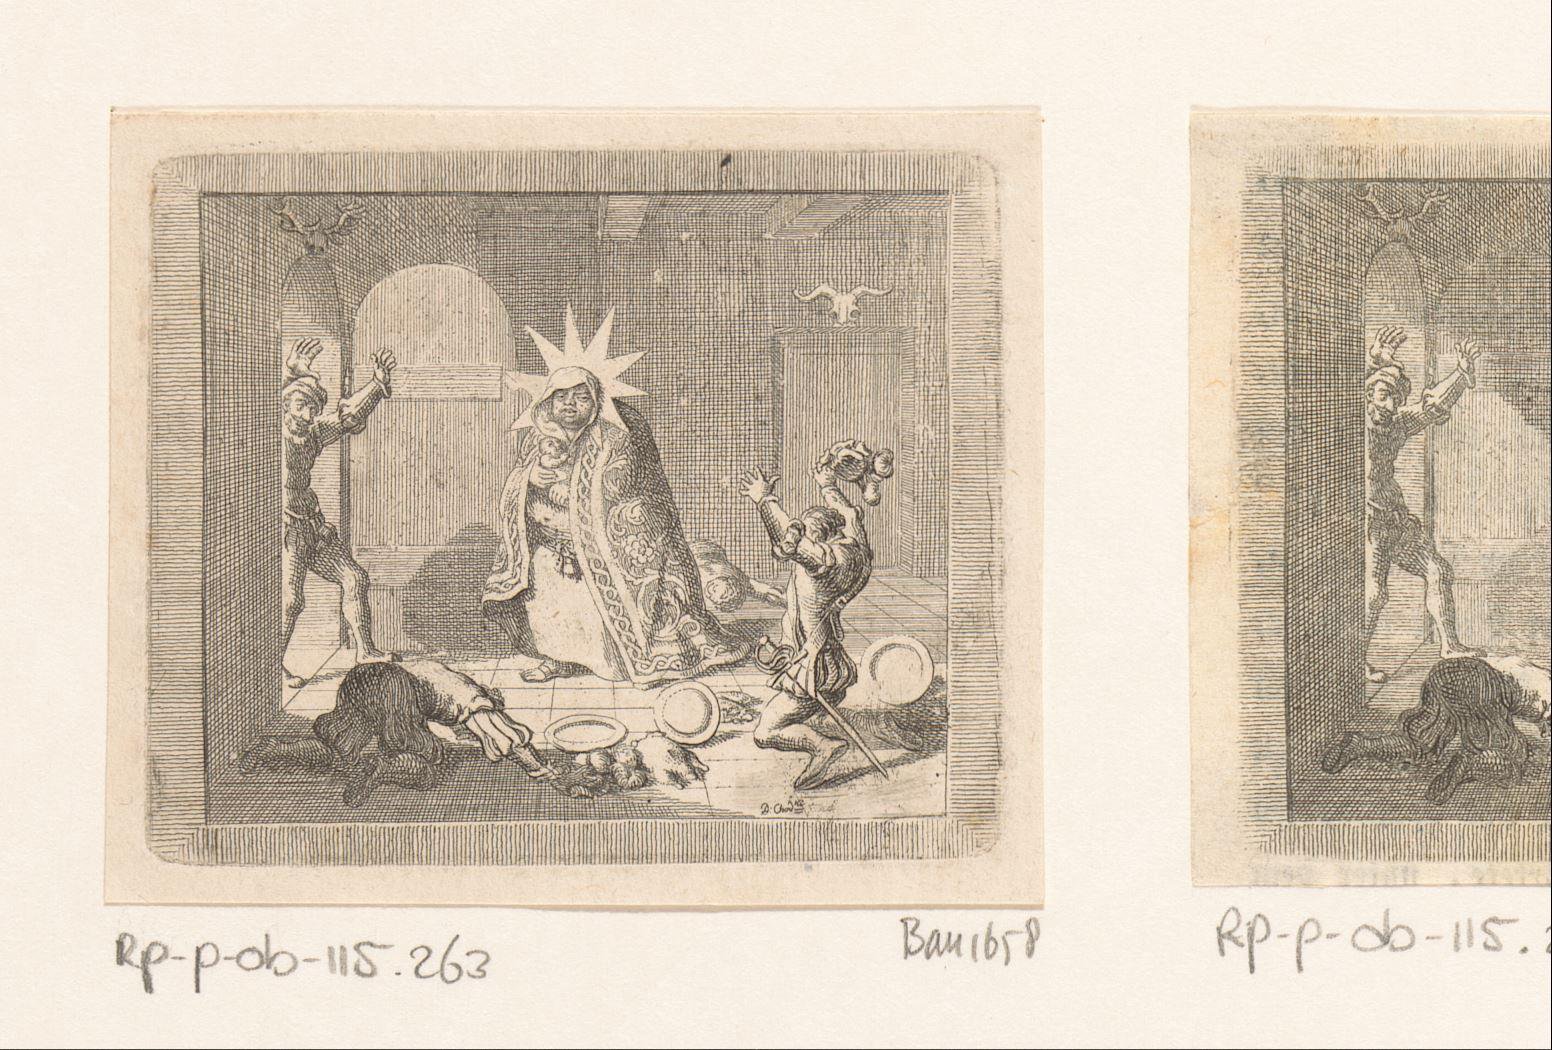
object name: print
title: Gramsalbus verkleedt zich als Maria en ontsnapt uit de gevangenis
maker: daniel nikolaus chodowiecki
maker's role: draughtsman, print maker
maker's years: 1726-1801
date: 1793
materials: paper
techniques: etching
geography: berlin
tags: escape, escape attempts, madonna: i.e. mary with the christ-child, literature, star-shaped nimbus, disguise, kneeling figure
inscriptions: collector's mark: Lugt 2228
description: Latere staat gebruikt voor: Wächter, Leonhard. Holzschnitte. Die Betfahrt des Bruders Gramsalbeus. Berlijn: Friedrich Maurer, 1793.